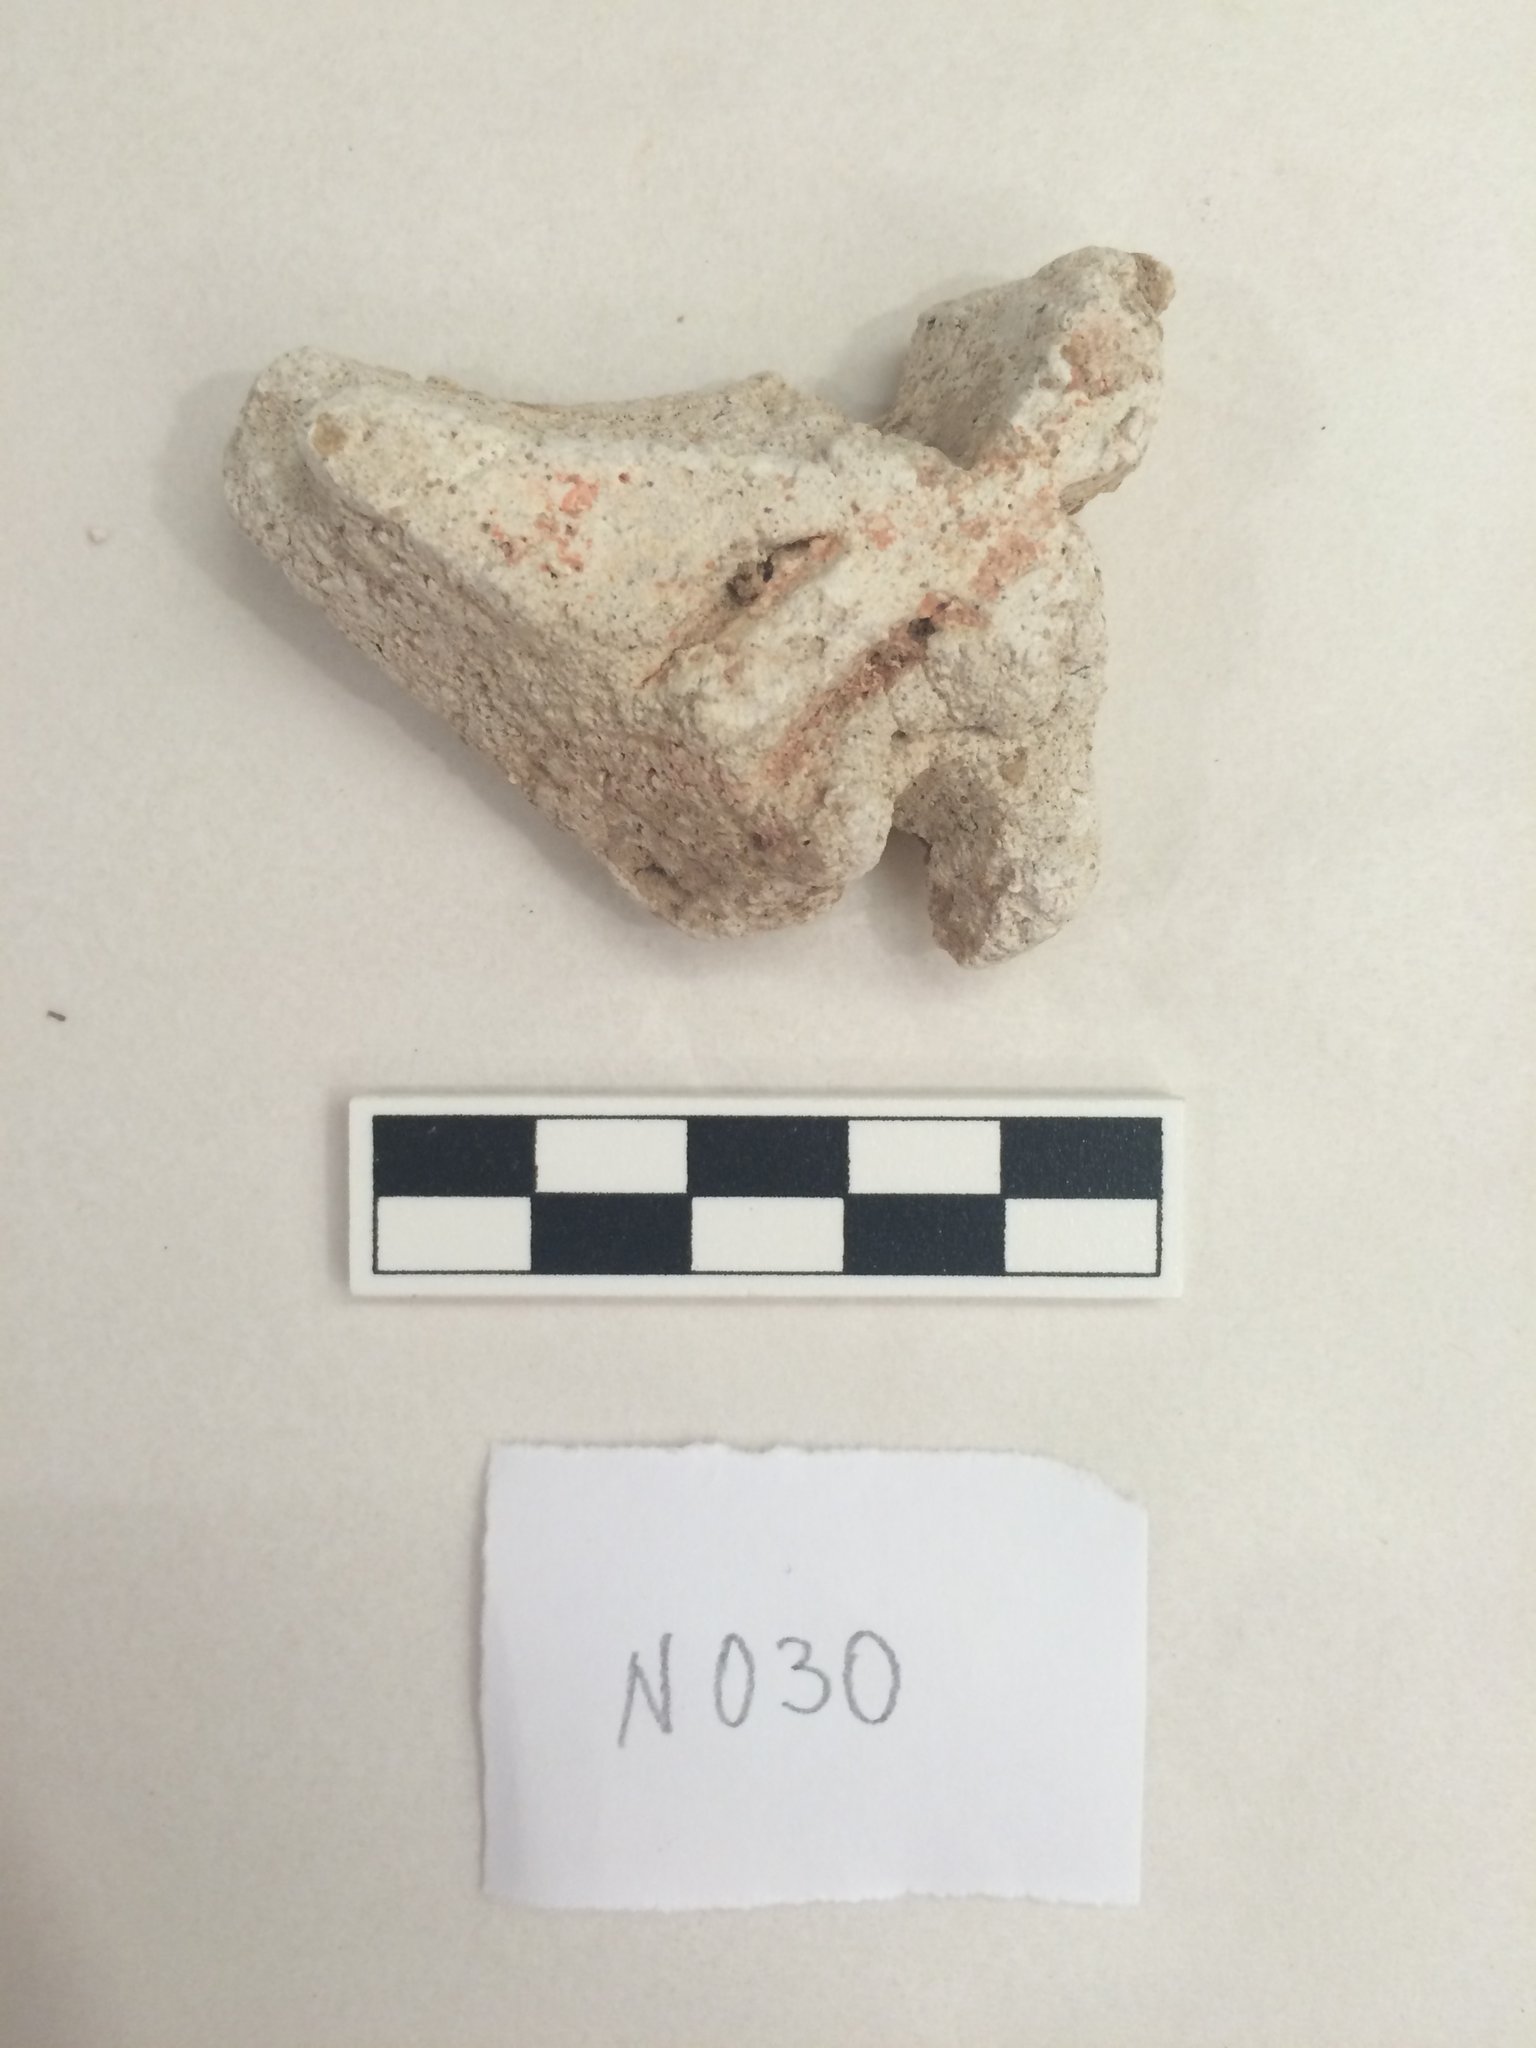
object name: fragment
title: Stucco Fragment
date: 701-1200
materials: plaster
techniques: carving, painting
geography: iran